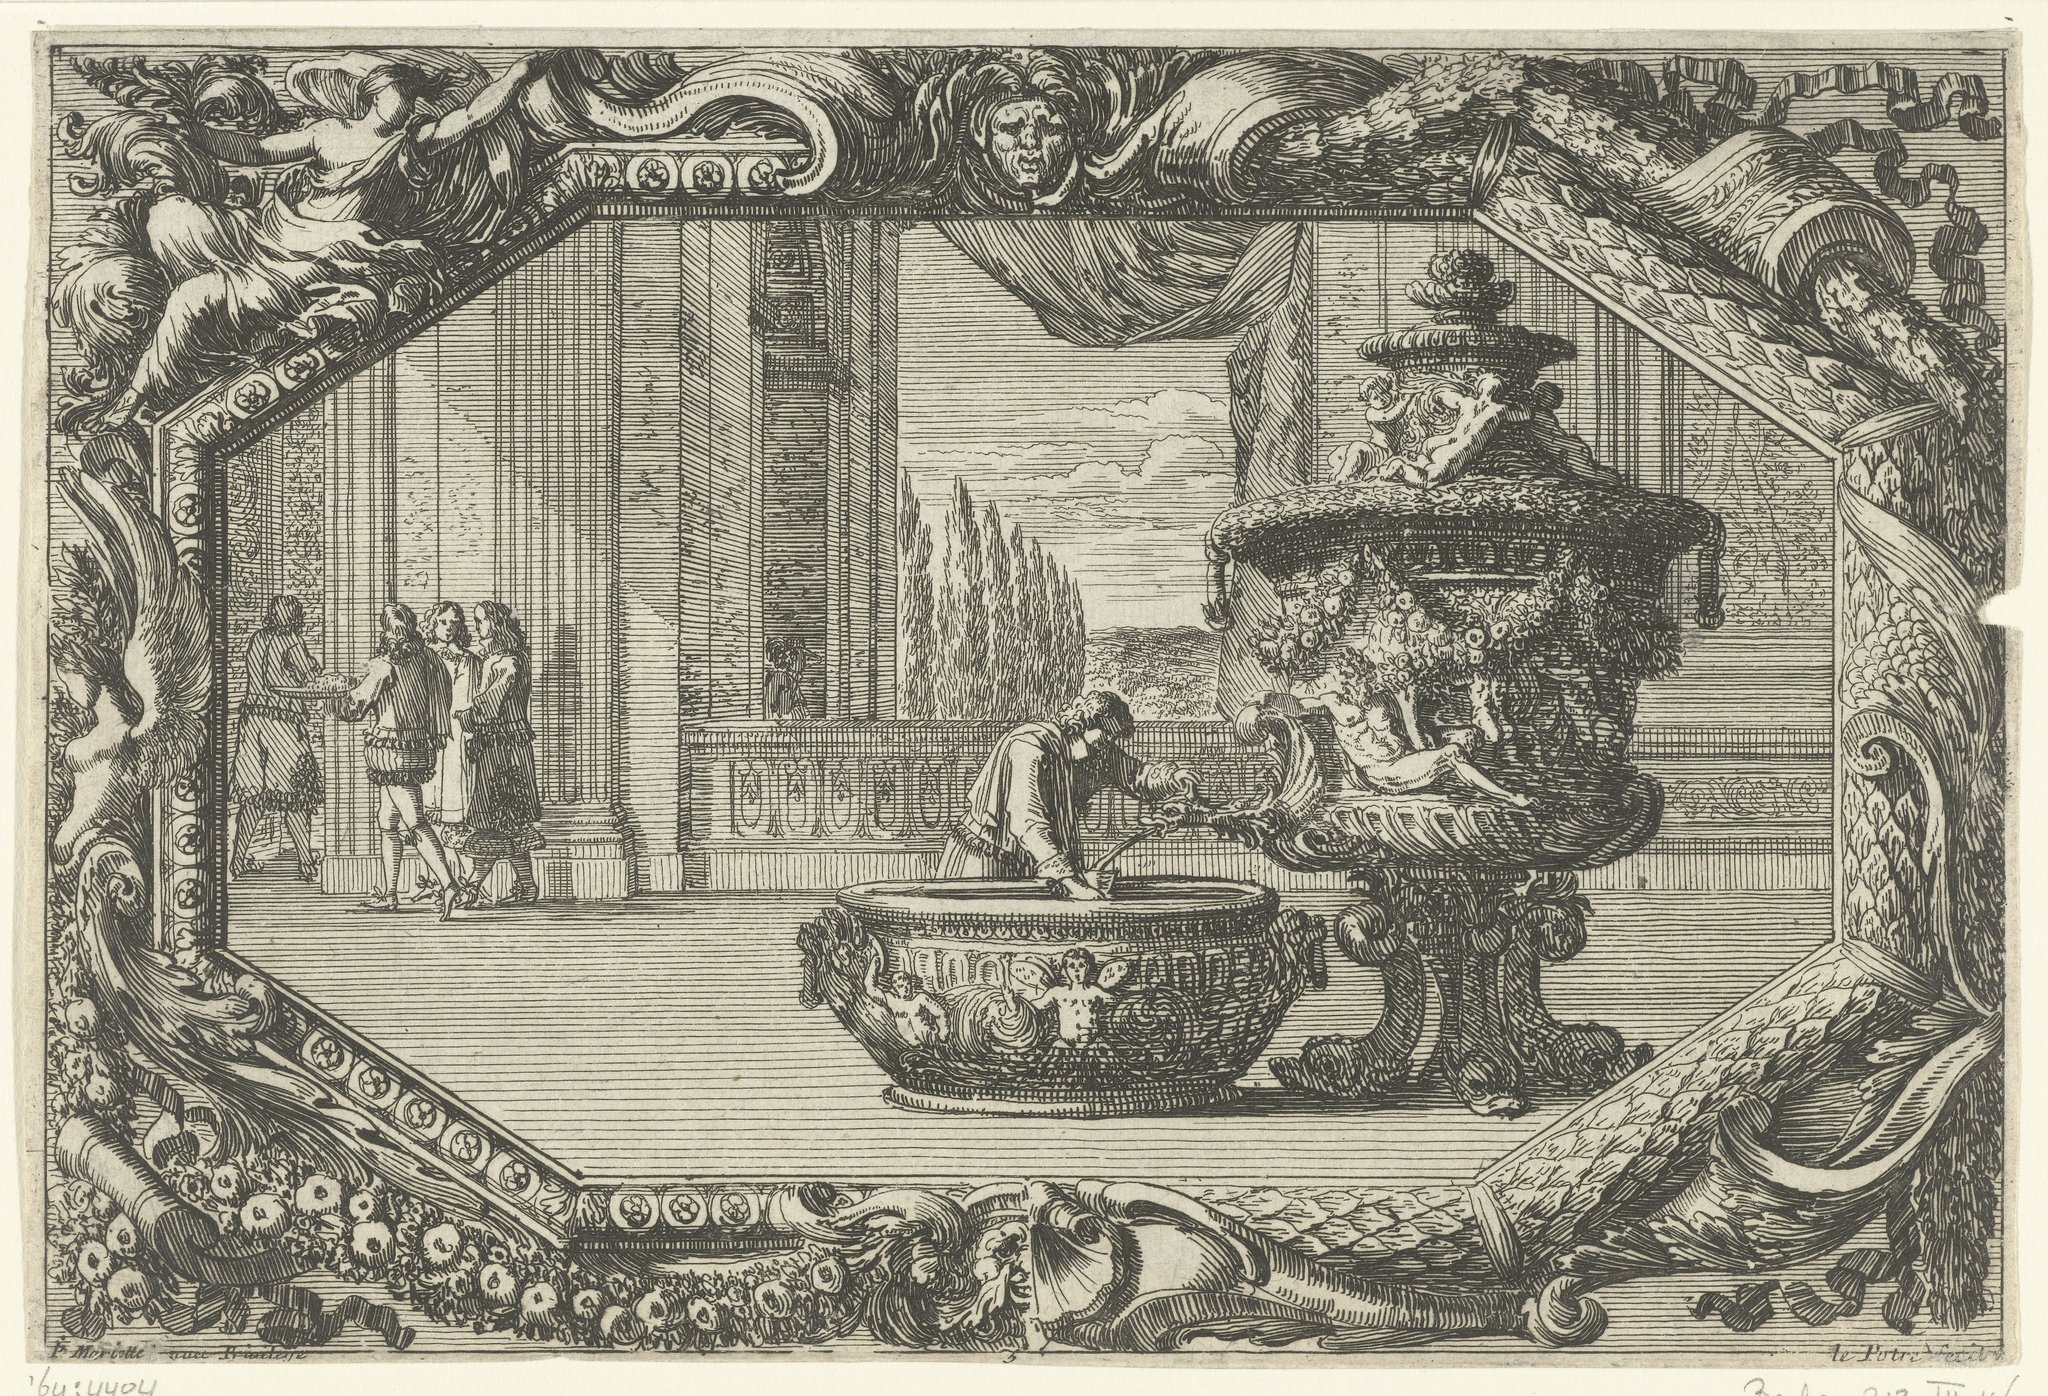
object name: ornament print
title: Mobiele waterfonteinen en waterbassins in cartouches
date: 1657-1661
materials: paper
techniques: etching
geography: paris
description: Waterfontein in de vorm van een urn rustend op vier dolfijnen. Uit derde editie.